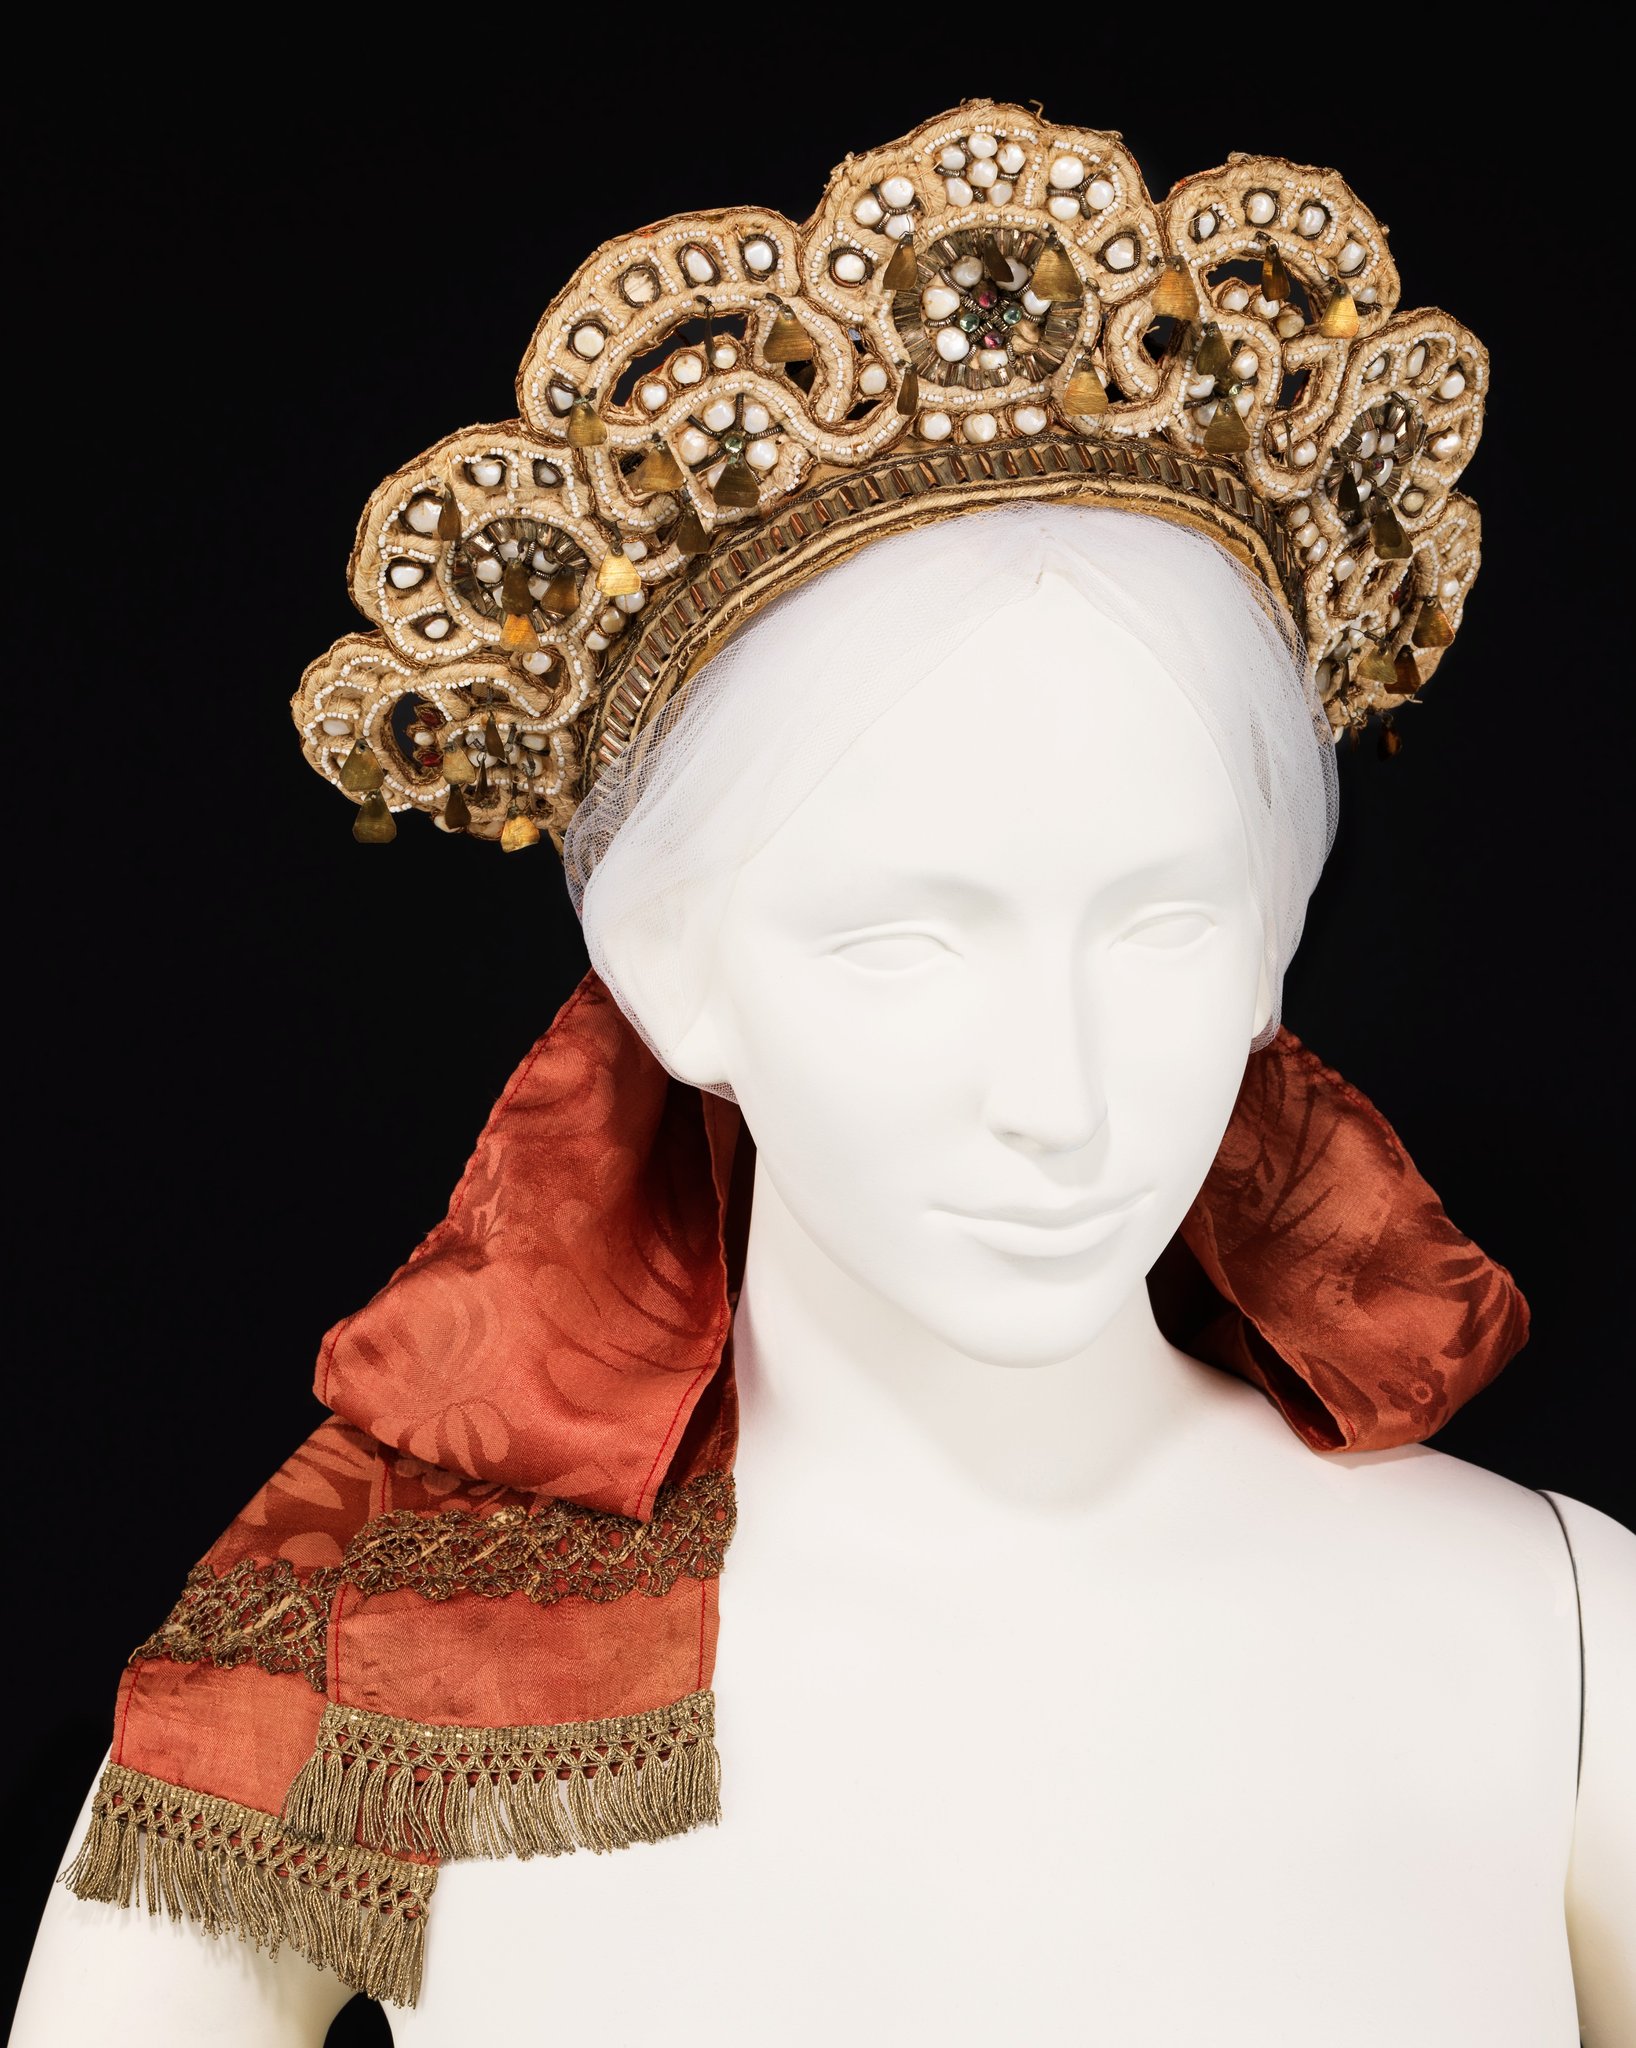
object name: wedding headdress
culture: russian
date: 1867-1900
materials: cotton, glass, metal, mother of pearl, paper, silk